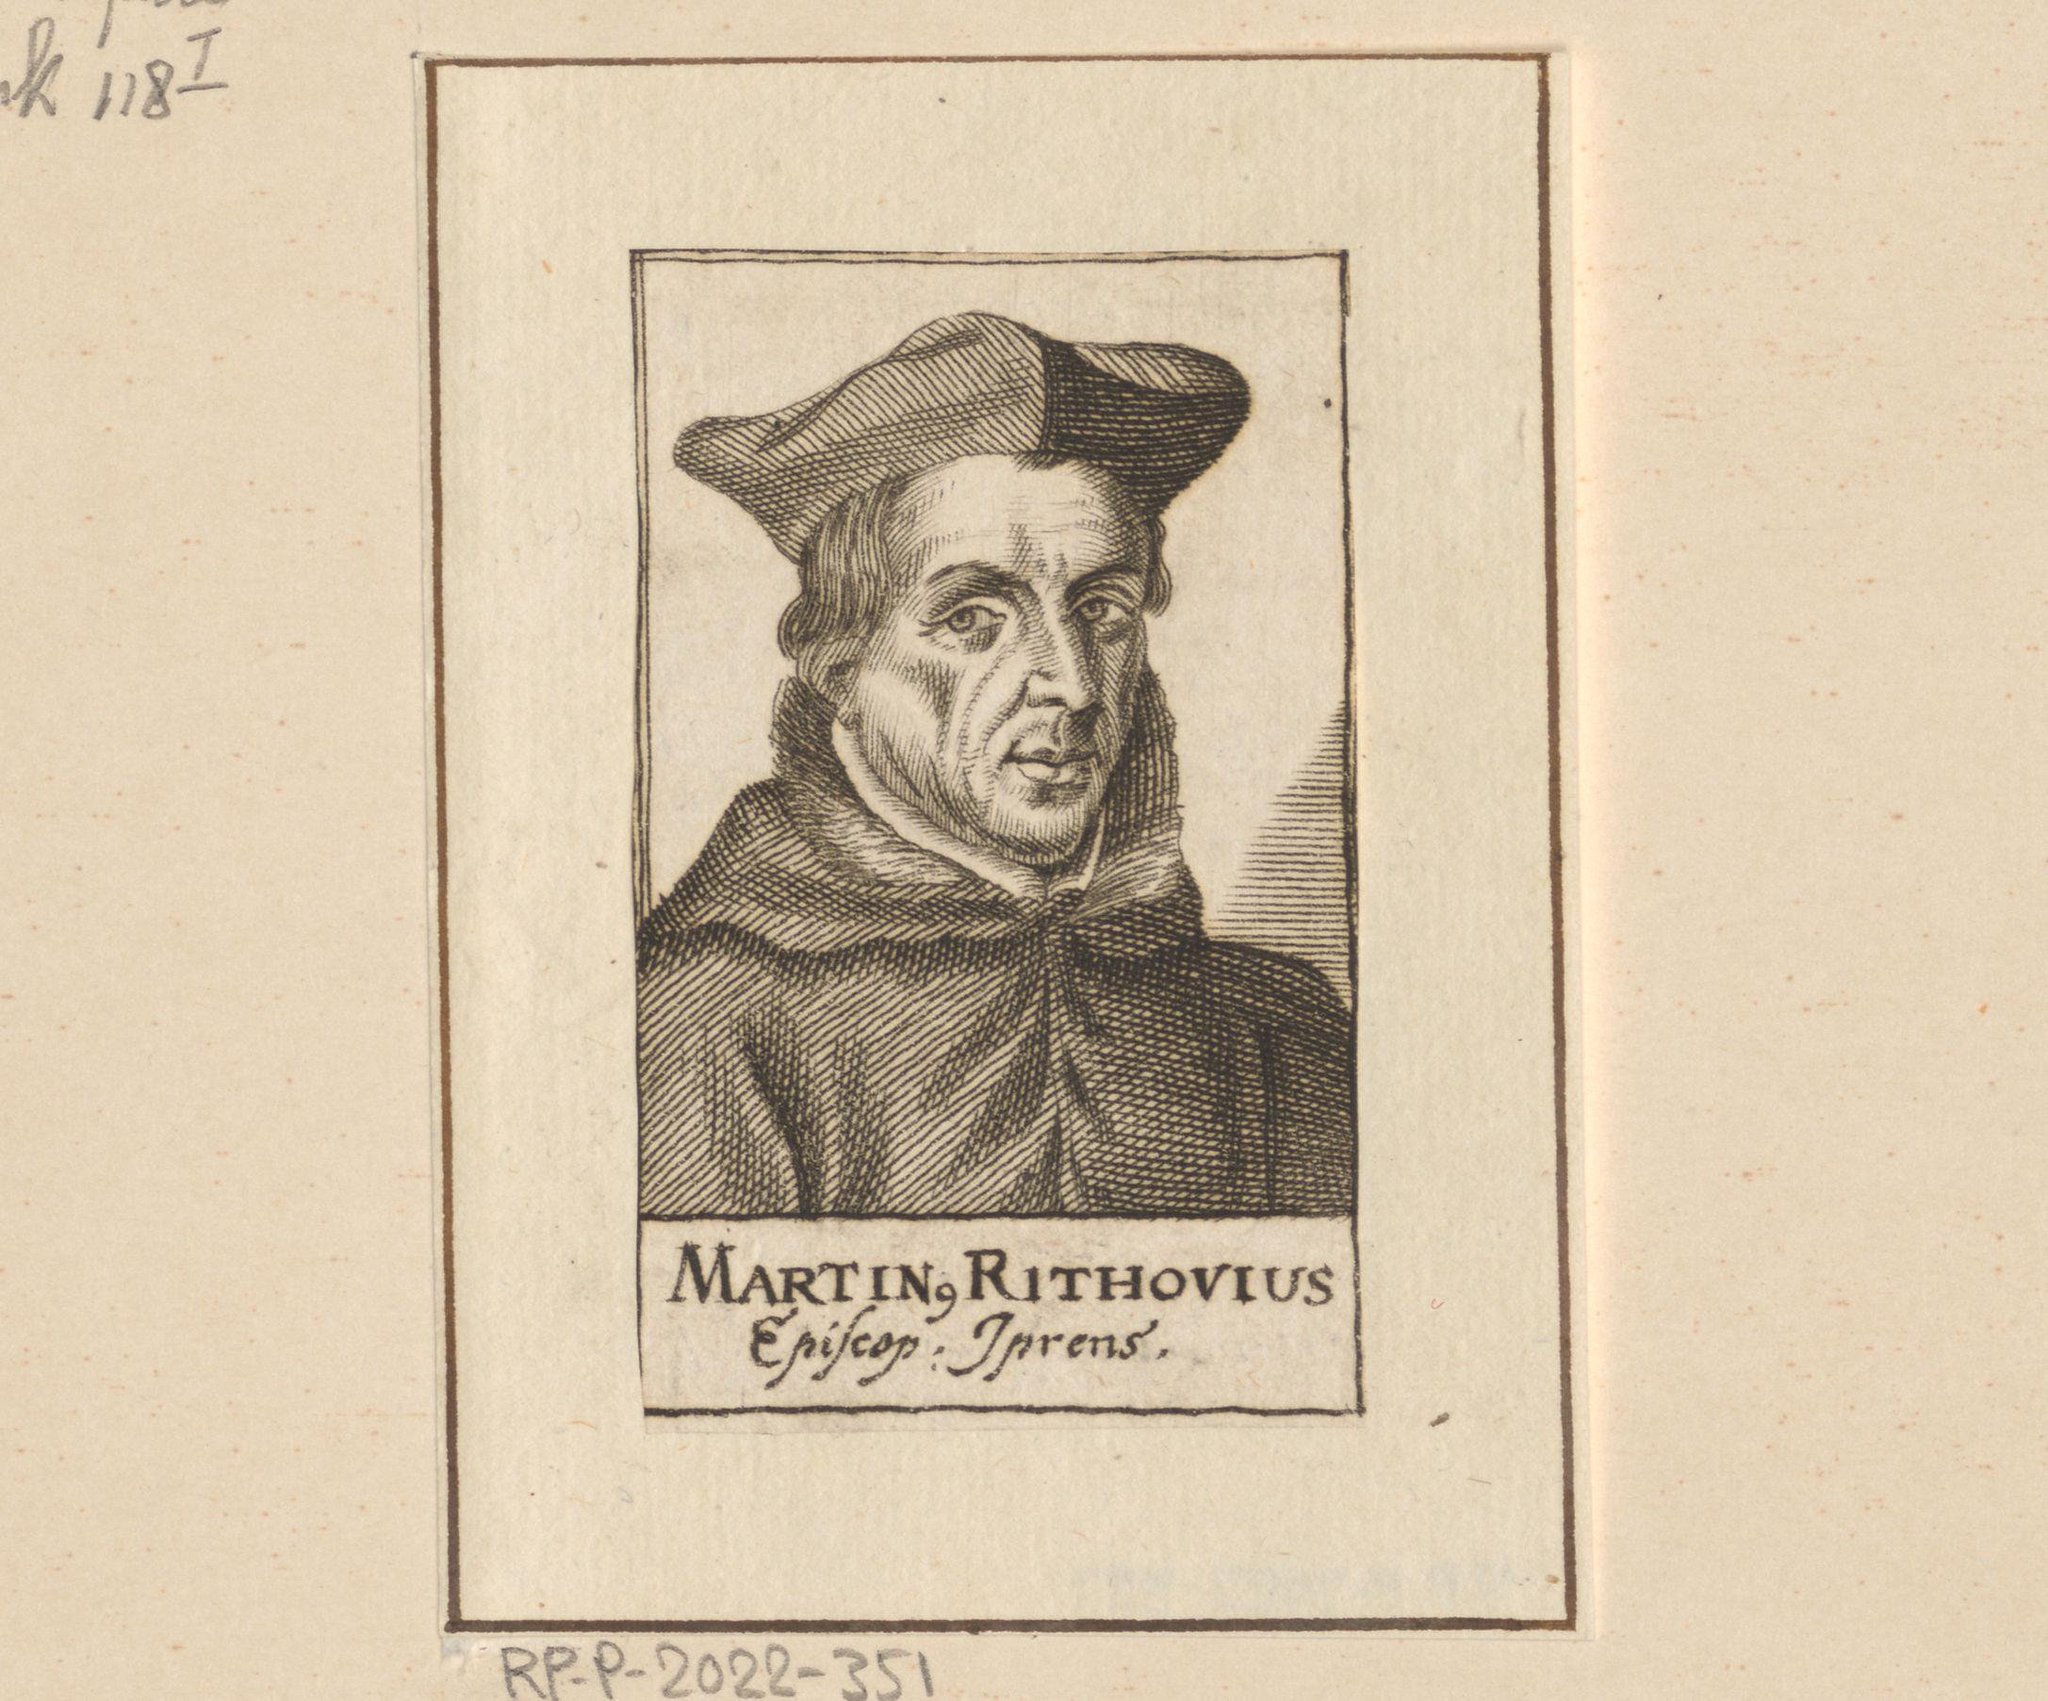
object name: print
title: Portret van Martinus Riethovius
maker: Anonymous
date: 1688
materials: paper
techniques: engraving, etching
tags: historical persons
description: Prent maakt deel uit van een grotere prent die later is verknipt. Prent waarschijnlijk uit: Freher, Paul. Theatrum virorum eruditione clarorum. Neurenberg: Johann Hoffmann, 1688.